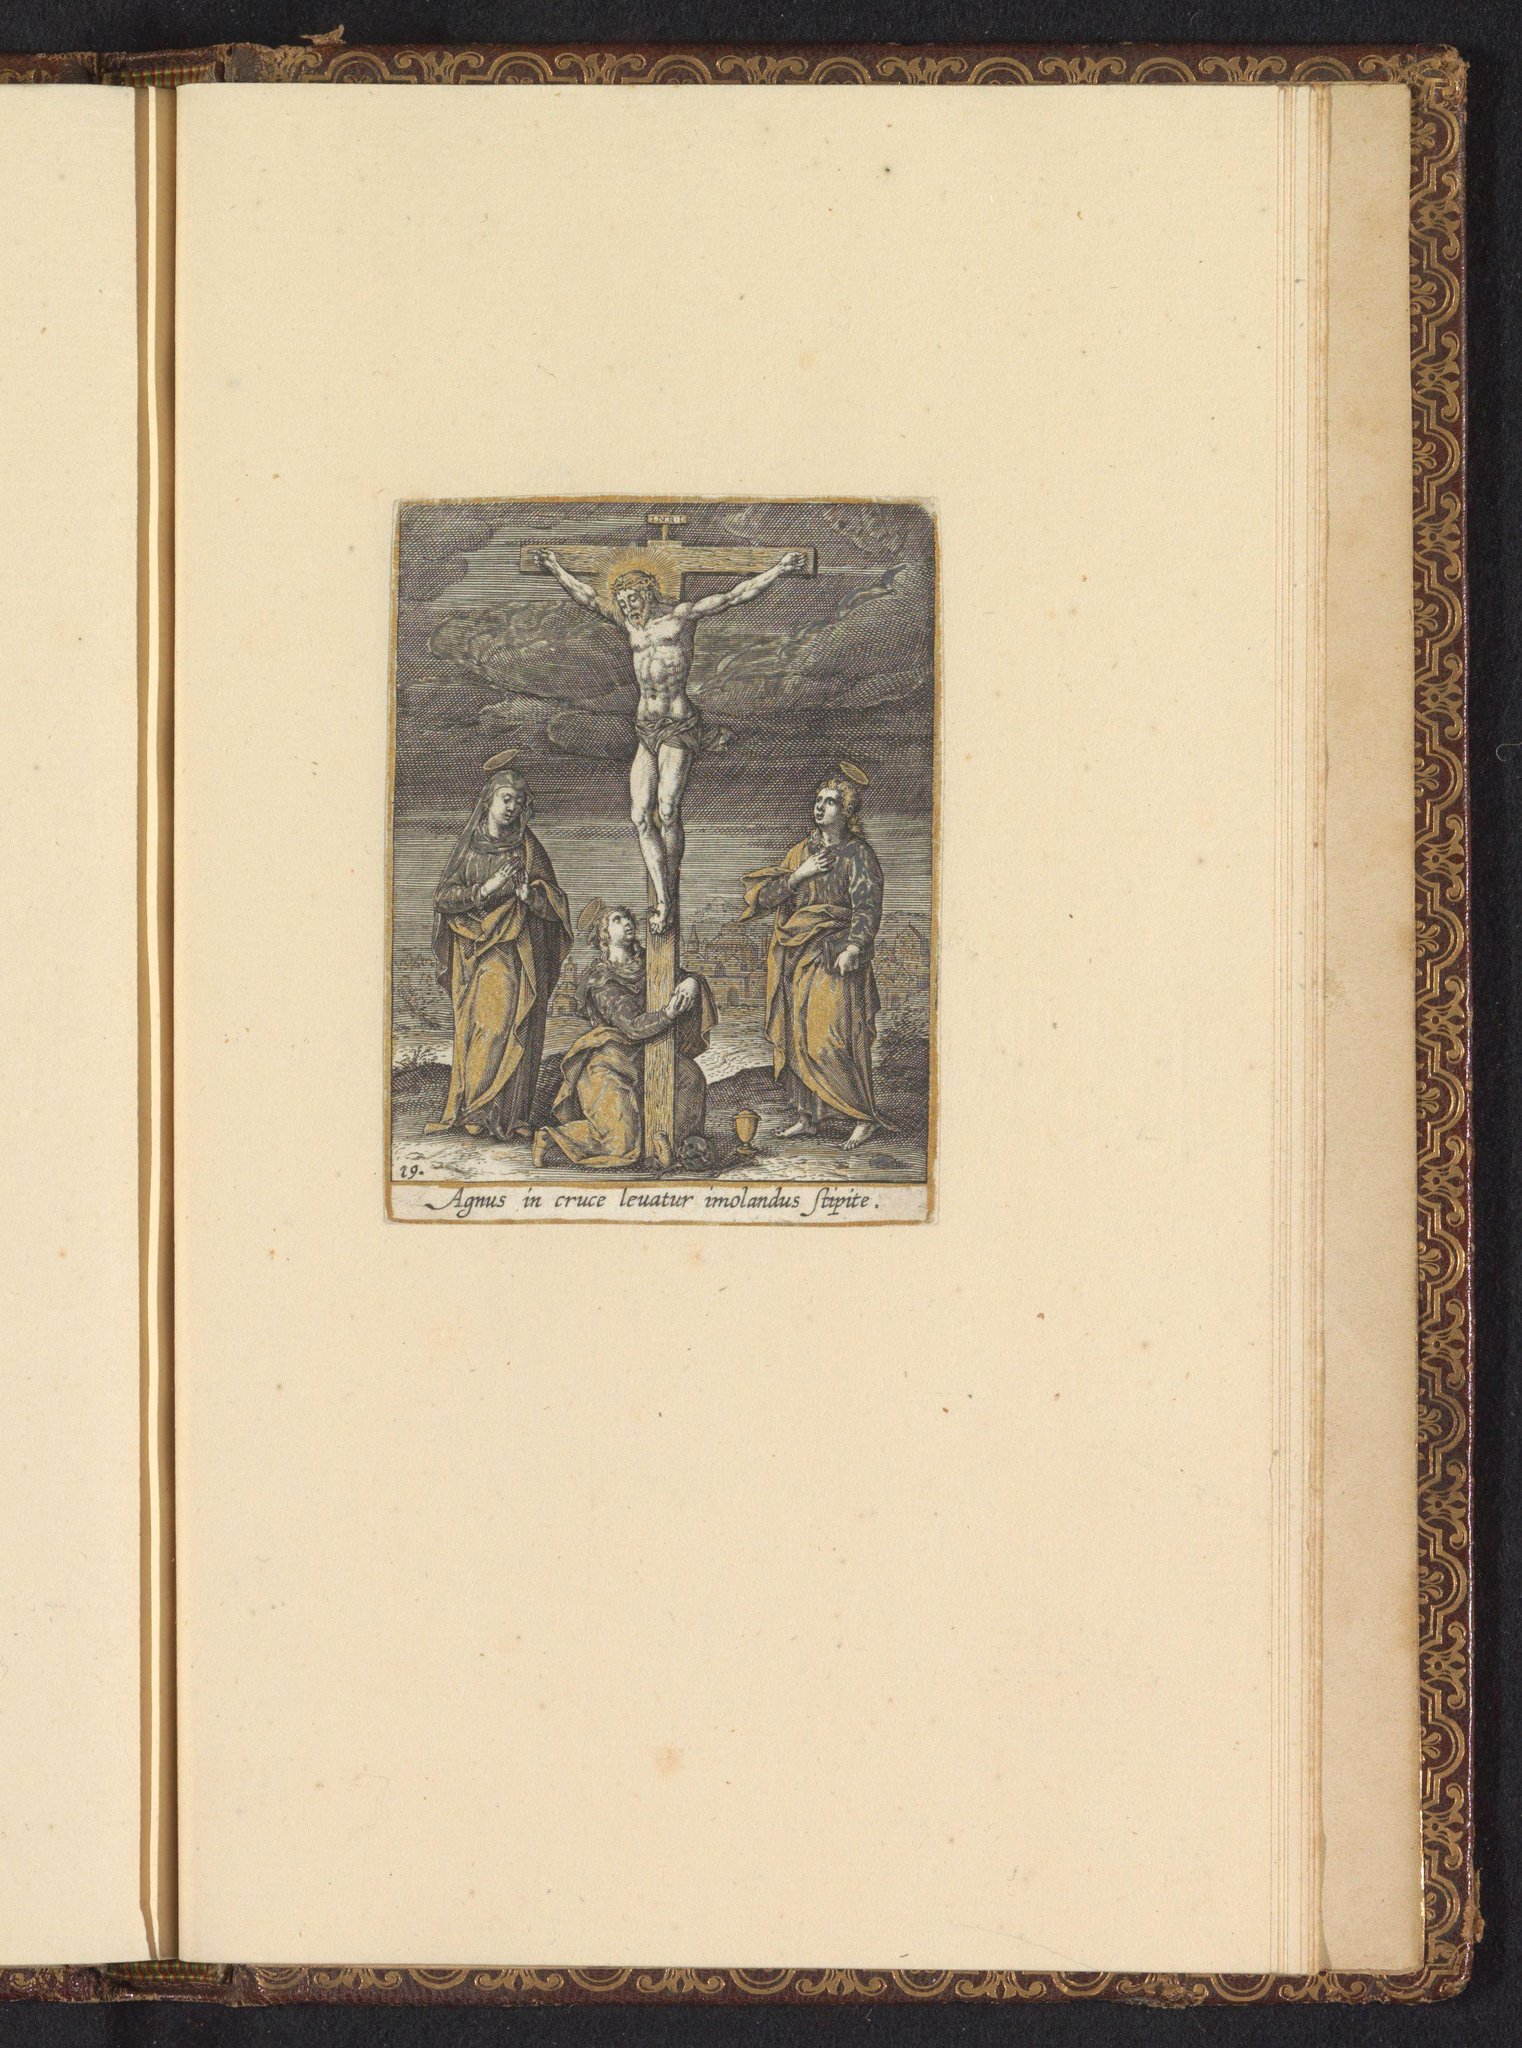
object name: print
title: Passio et resurrectio D.N. Iesu Christi. Edita et excusa ab Ad. Collaert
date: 1580-1590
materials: gold, paper, silver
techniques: engraving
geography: antwerp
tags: crucified christ with mary, john, and mary magdalene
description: Christus aan het kruis, met Maria, Maria Magdalena en Johannes. Onderdeel van de prentserie over de passie van Christus: Passio et resurrectio D.N. Iesu Christi. Edita et excusa ab Ad. Collaert. In prentalbum met twee reeksen van respectievelijk 34 en 24 gravures met scènes uit het leven en het lijdensverhaal van Christus.